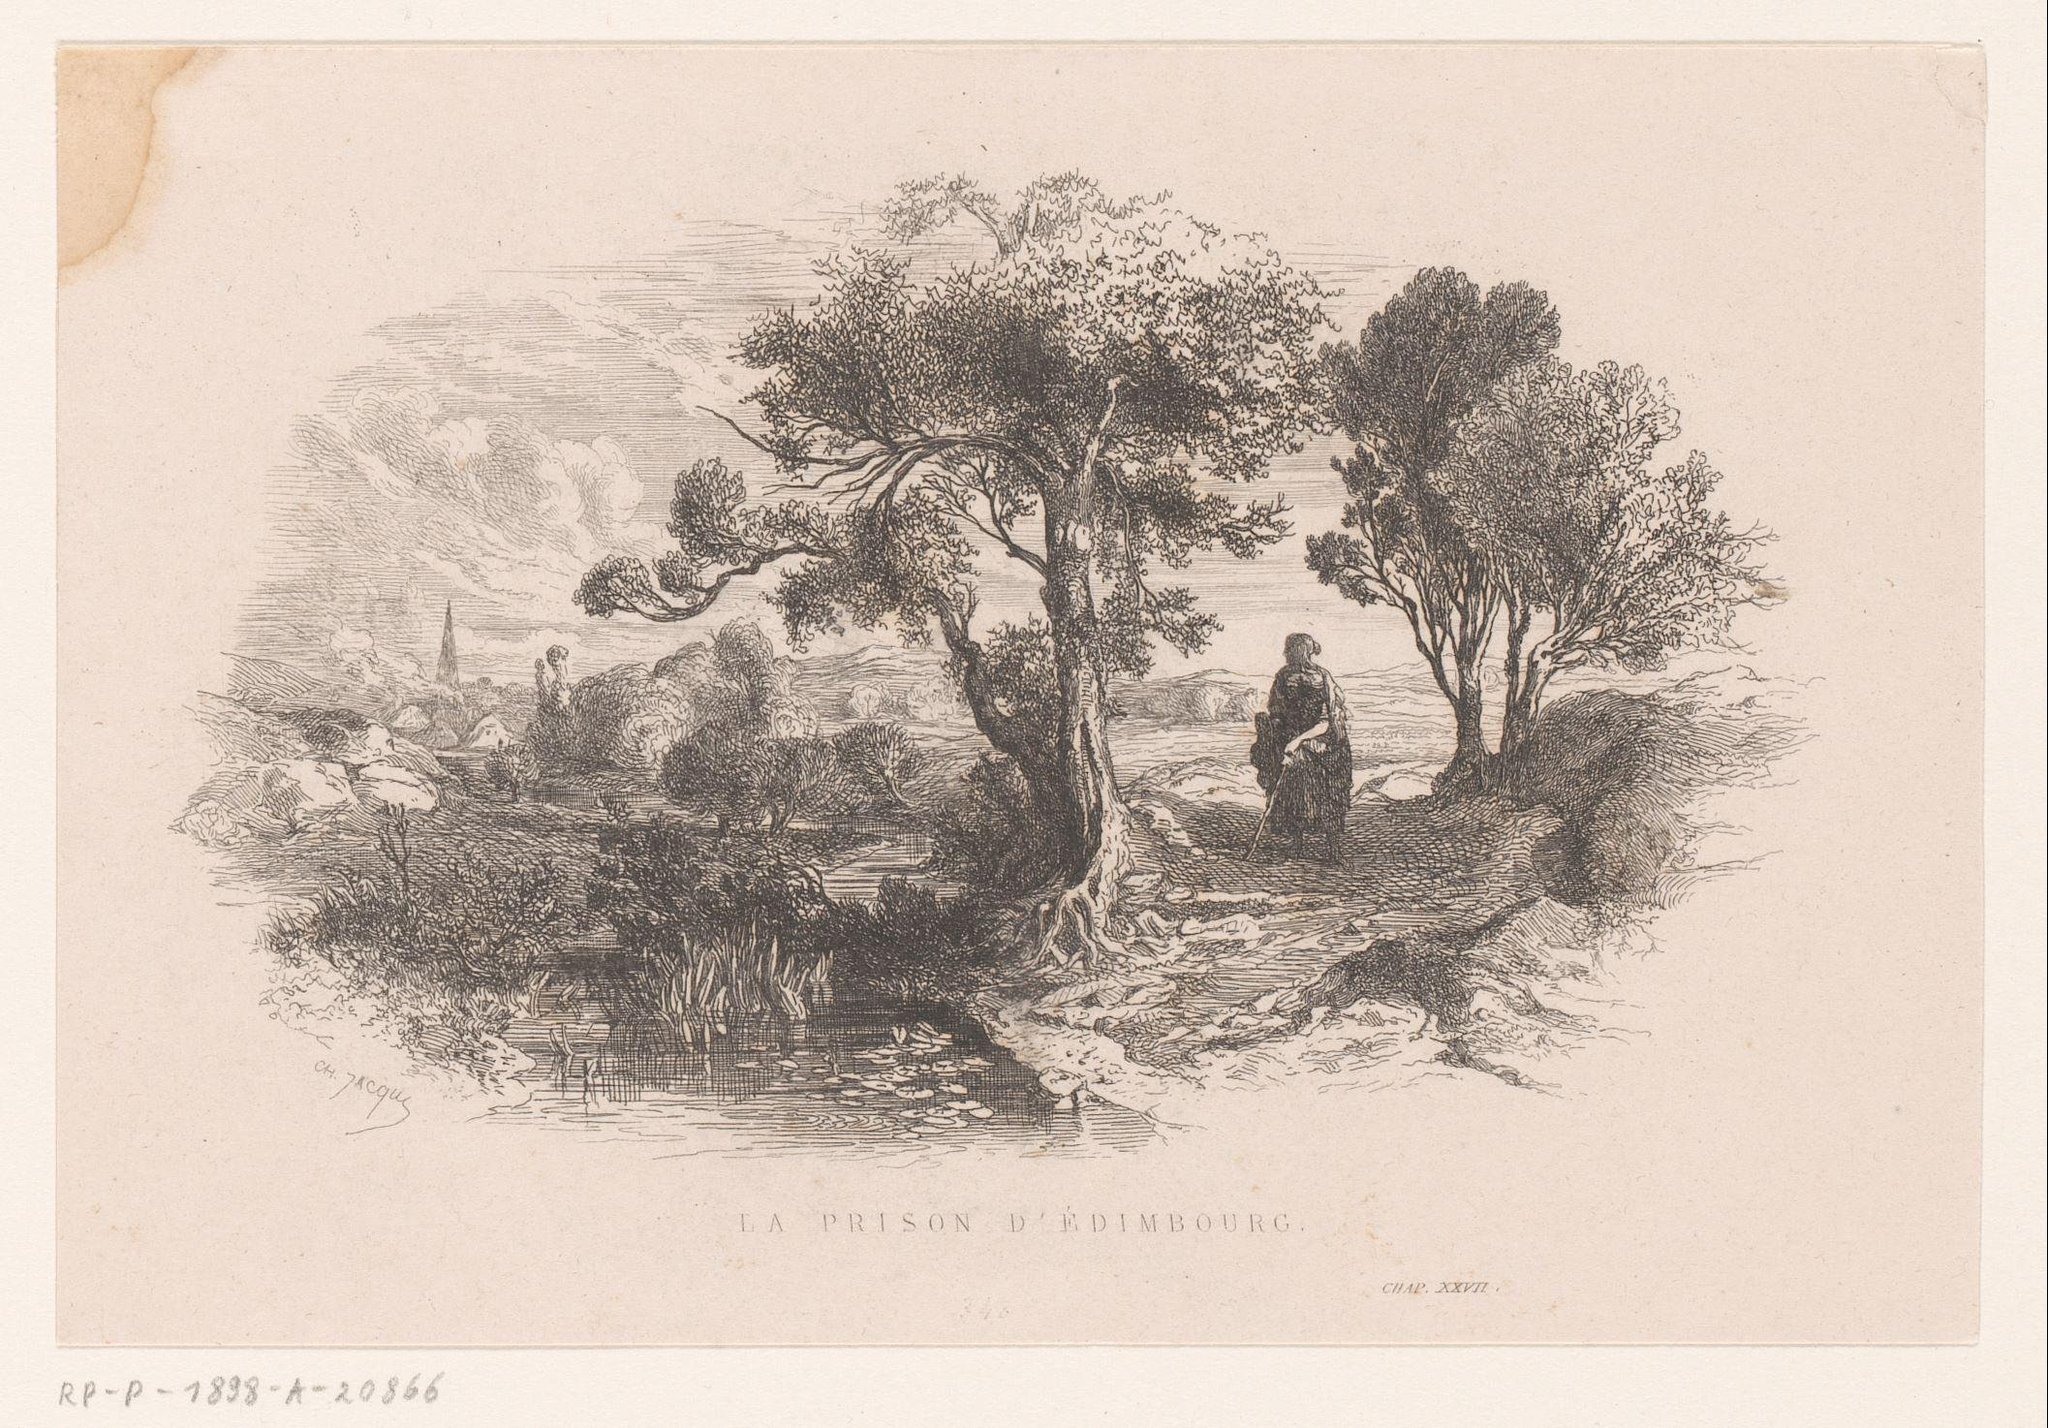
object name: print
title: La prison d'Édimbourg.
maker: charles emile jacque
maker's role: draughtsman, painter, print maker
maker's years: 1813-1894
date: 1844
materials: paper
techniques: etching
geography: france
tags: adult woman, water course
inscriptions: collector's mark: Lugt 964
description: Prent uit: Oeuvres de Walter Scott. Parijs: Firmin-Didot, 1844.